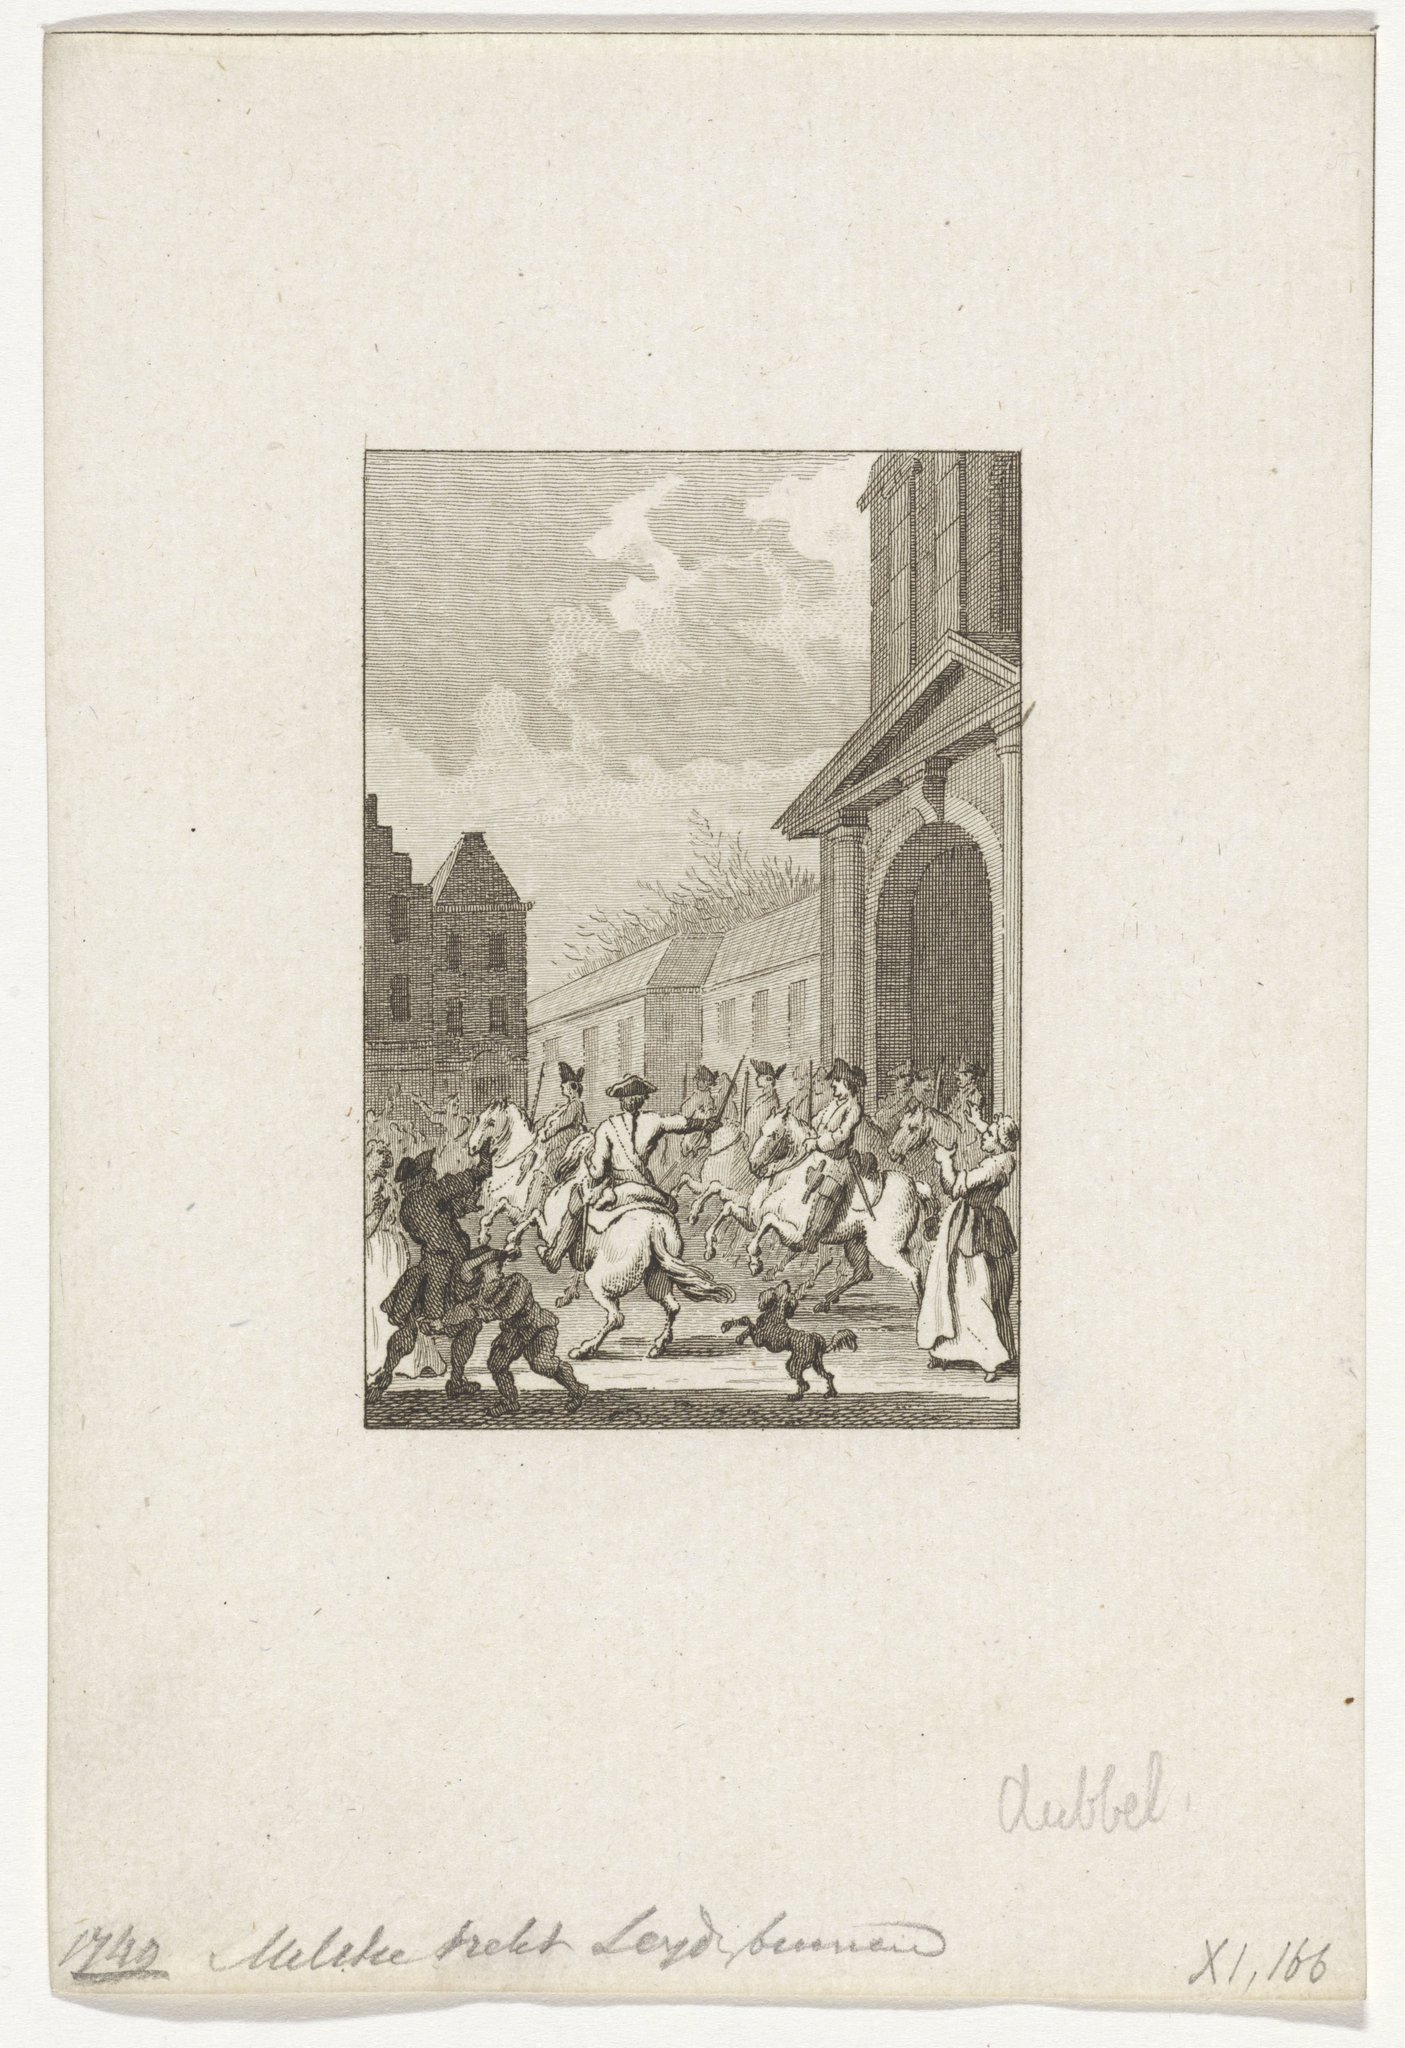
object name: print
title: Dragonders trekken door de Witte Poort Leiden in, 1748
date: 1783-1795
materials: paper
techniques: etching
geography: amsterdam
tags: aken, pachtersoproer (1747-1750)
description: Illustratie voor: J. Fokke. Geschiedenissen der Vereenigde Nederlanden voor de vaderlandsche jeugd. Amsterdam: Johannes Allart, 1783-1795, 25 delen. deel XI.